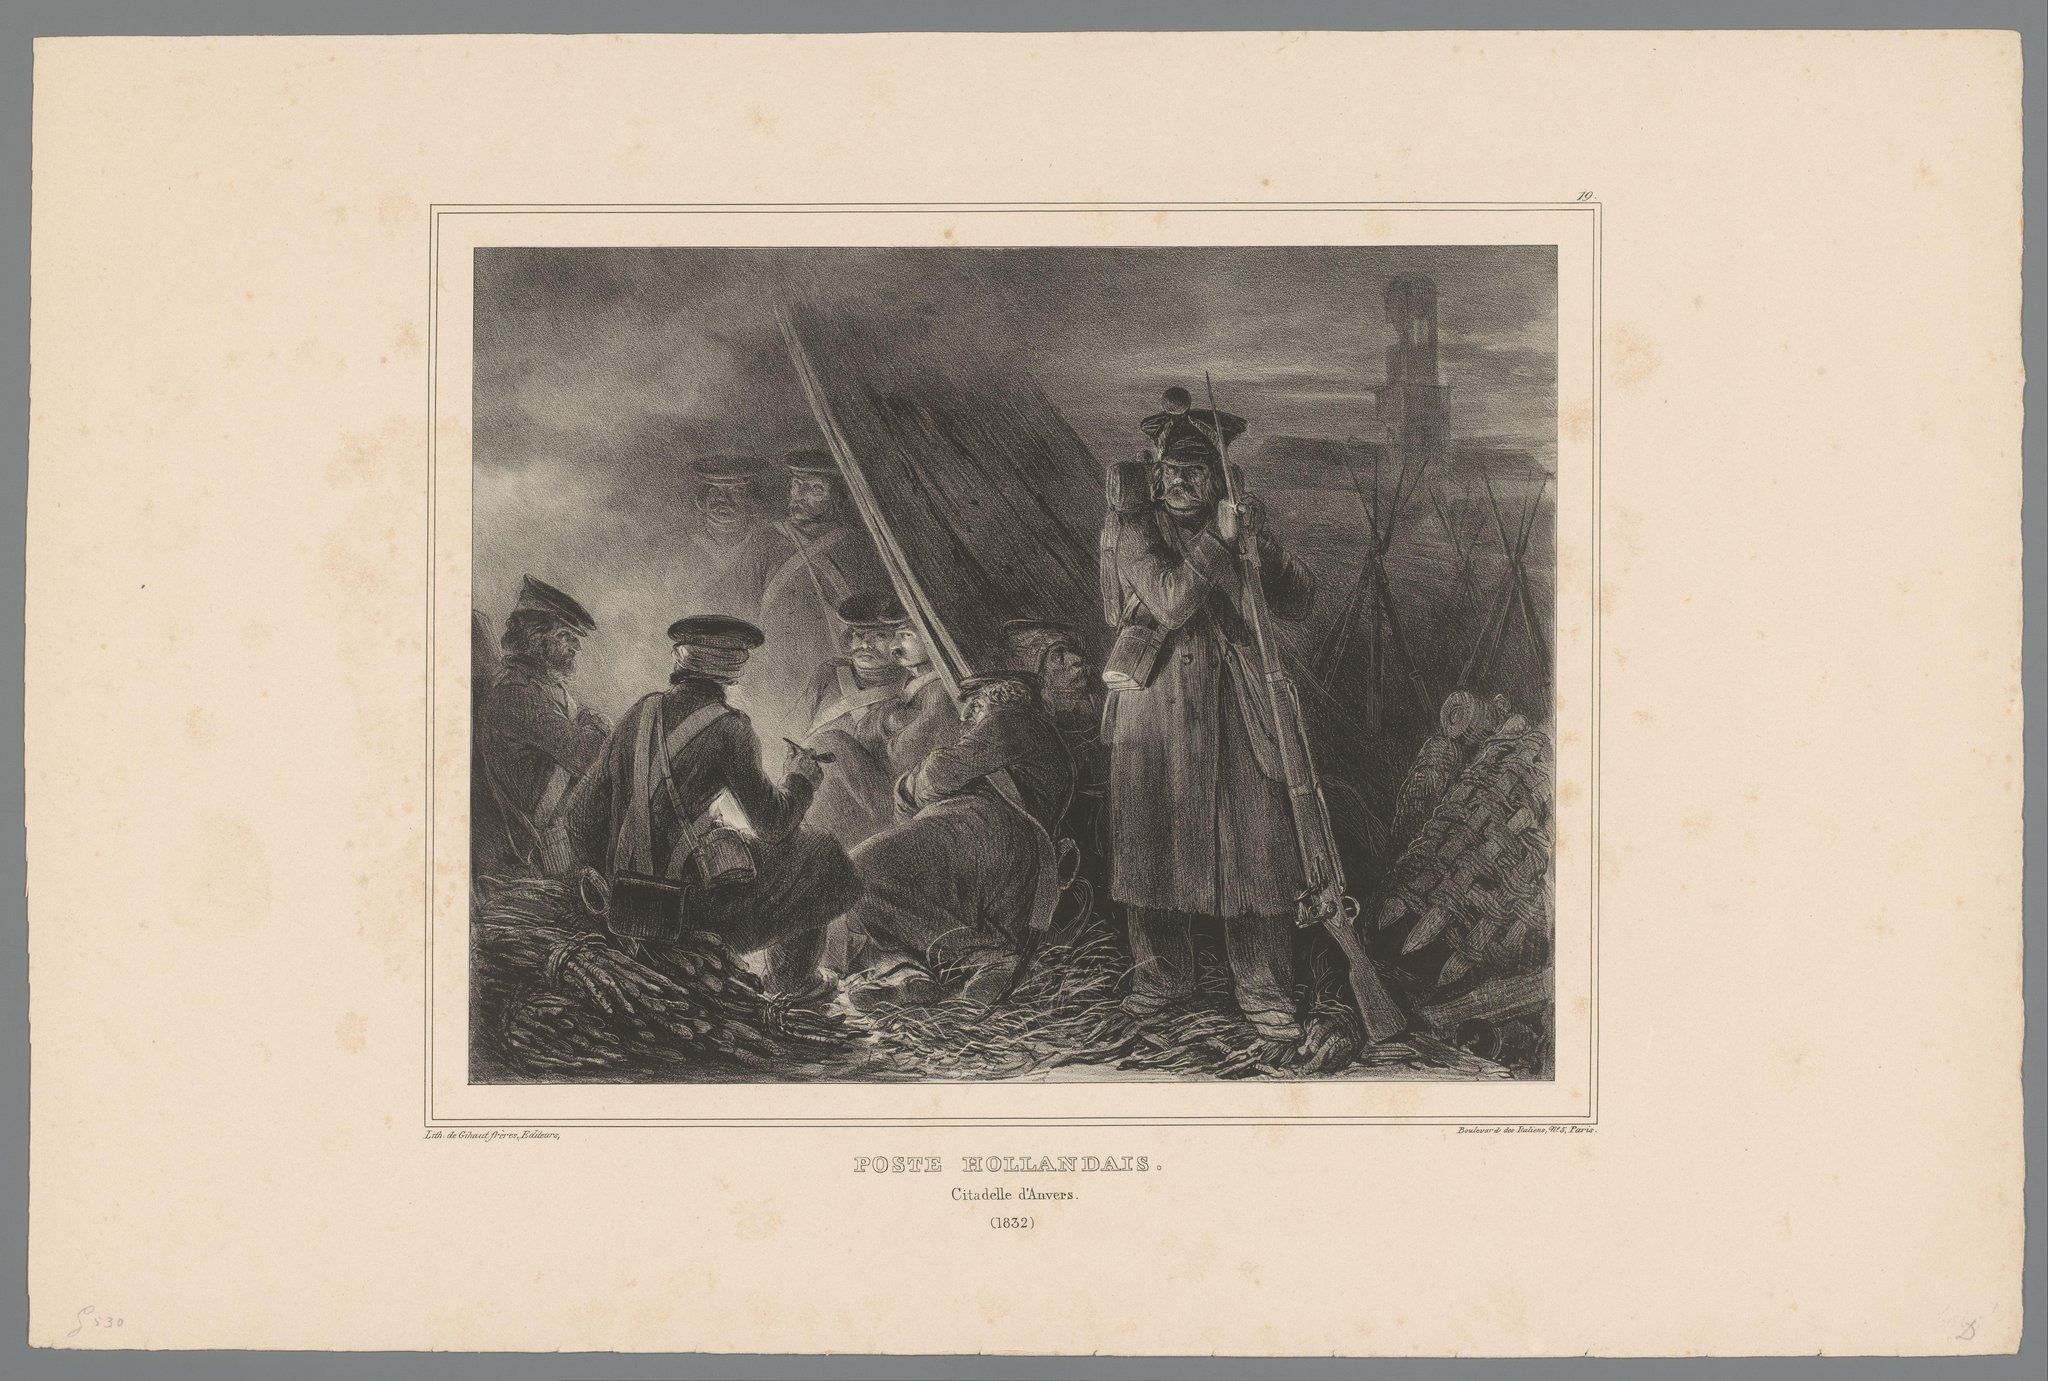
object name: print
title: Dessins faits d'après nature au siège de la Citadelle d'Anvers par Raffet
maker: denis auguste marie raffet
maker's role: draughtsman, print maker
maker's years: 1804-1860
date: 1833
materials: paper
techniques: lithograph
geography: paris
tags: (military) camp with tents, siege, position war, firearms: rifle, the soldier; the soldier's life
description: Rustende Nederlandse soldaten bij een vuurtje; rechts op de achtergrond ruïne van een toren. Onderdeel van de serie van 24 prenten over het beleg van de Citadel van Antwerpen, 30 november - 23 december 1832.